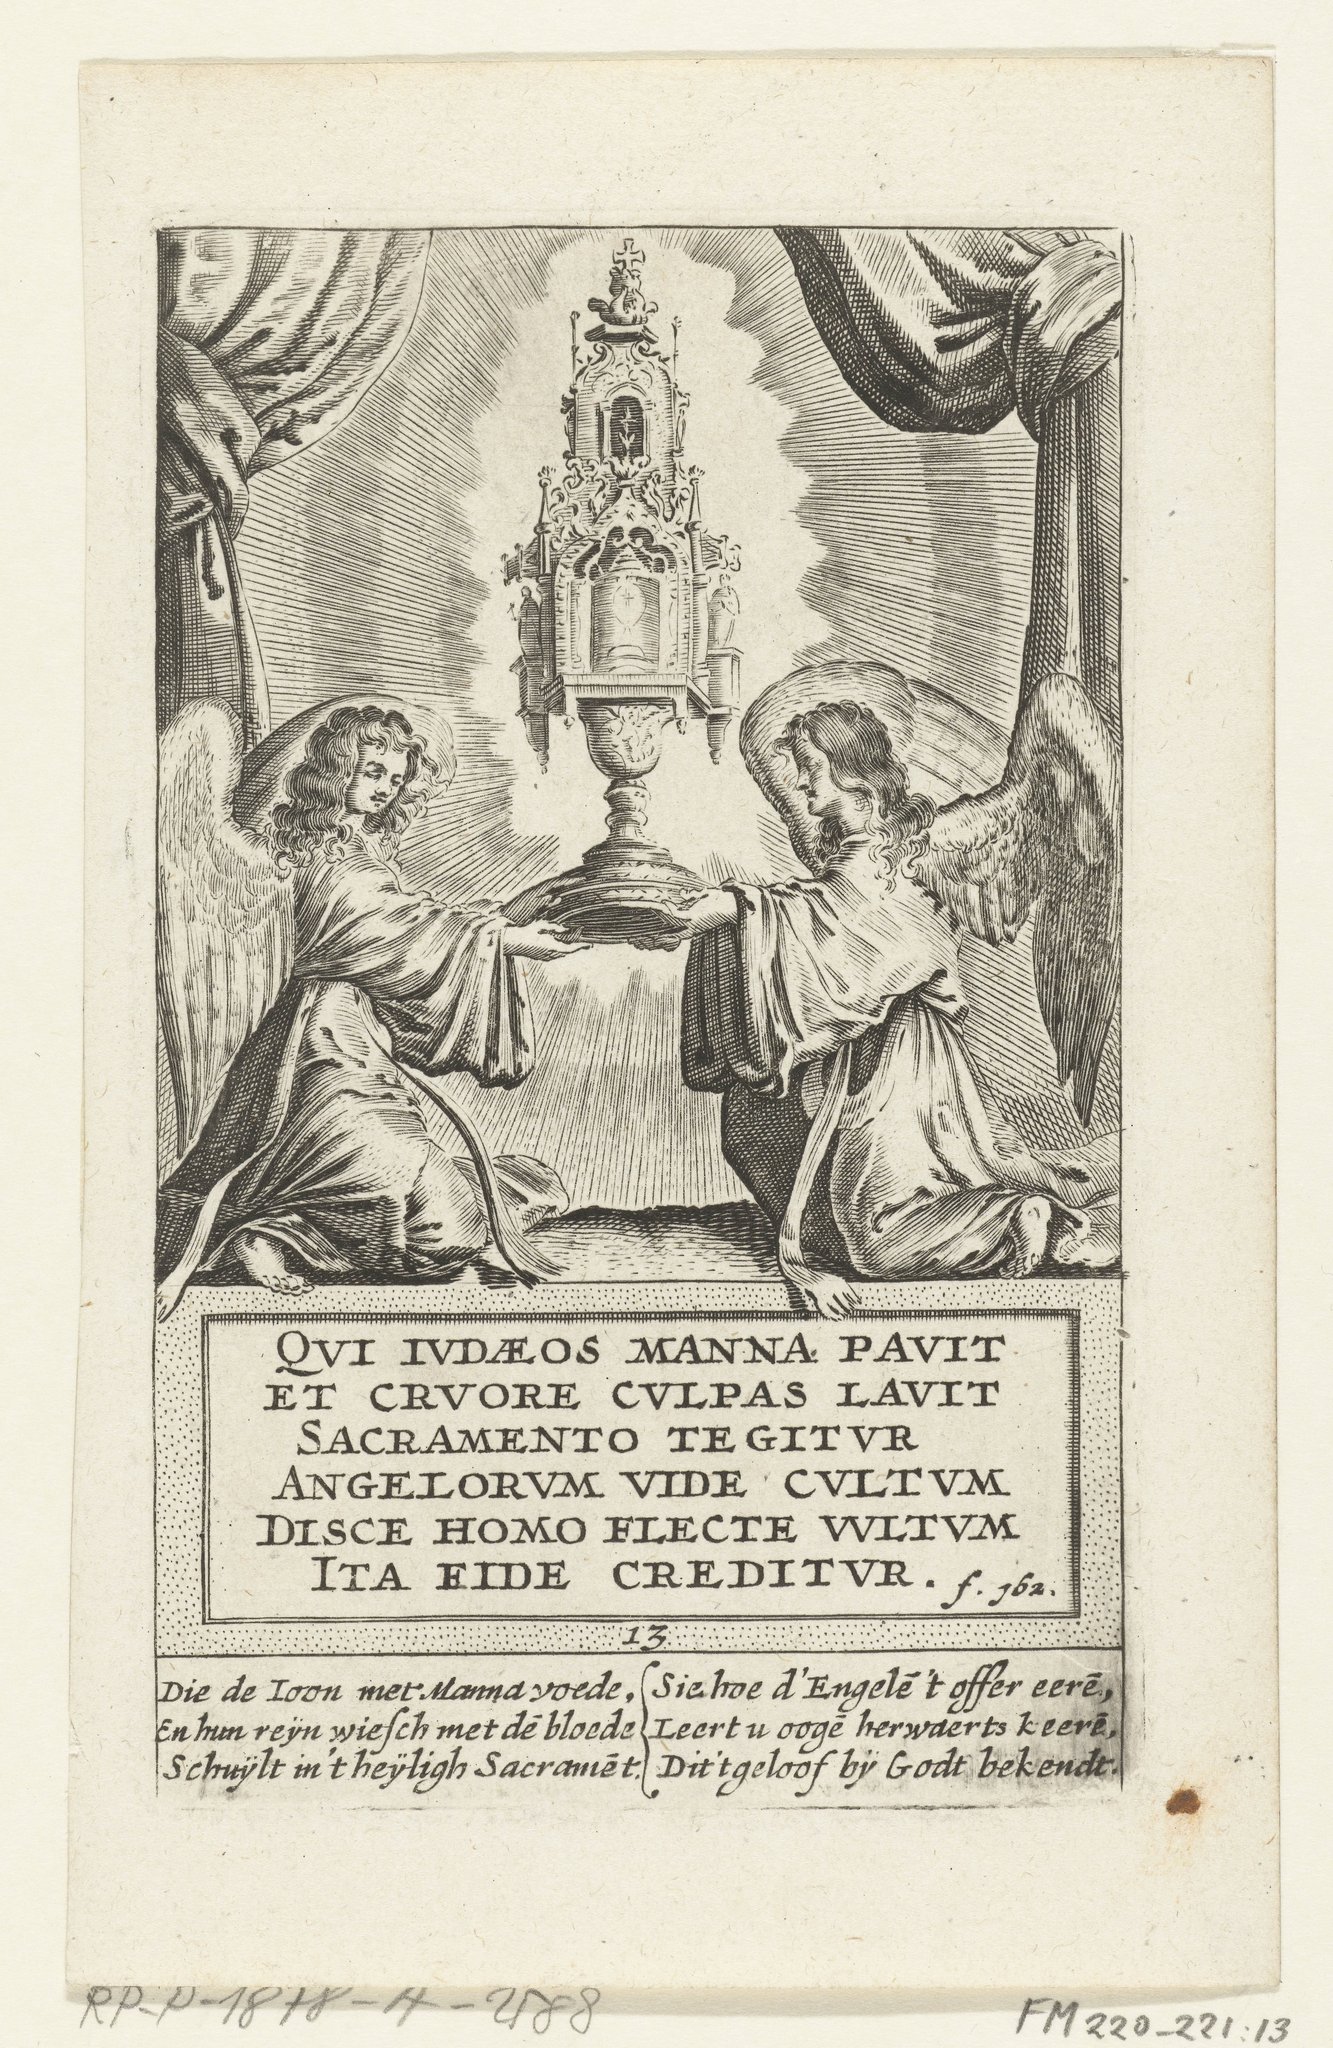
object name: print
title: Het Mirakel van Amsterdam, 1345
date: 1639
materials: paper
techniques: engraving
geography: southern netherlands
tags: ostensorium, monstrance, adoration of the host, e.g. perpetual adoration, amsterdam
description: Twee engelen met een monstrans waarin het H. Sacrament. Prent nr. 13 uit de serie van 16 voorstellingen van Het Mirakel van Amsterdam, naar de gebeurtenissen op 15 maart 1345. Onder de voorstelling twee zesregelige verzen in het Latijn en Nederlands.